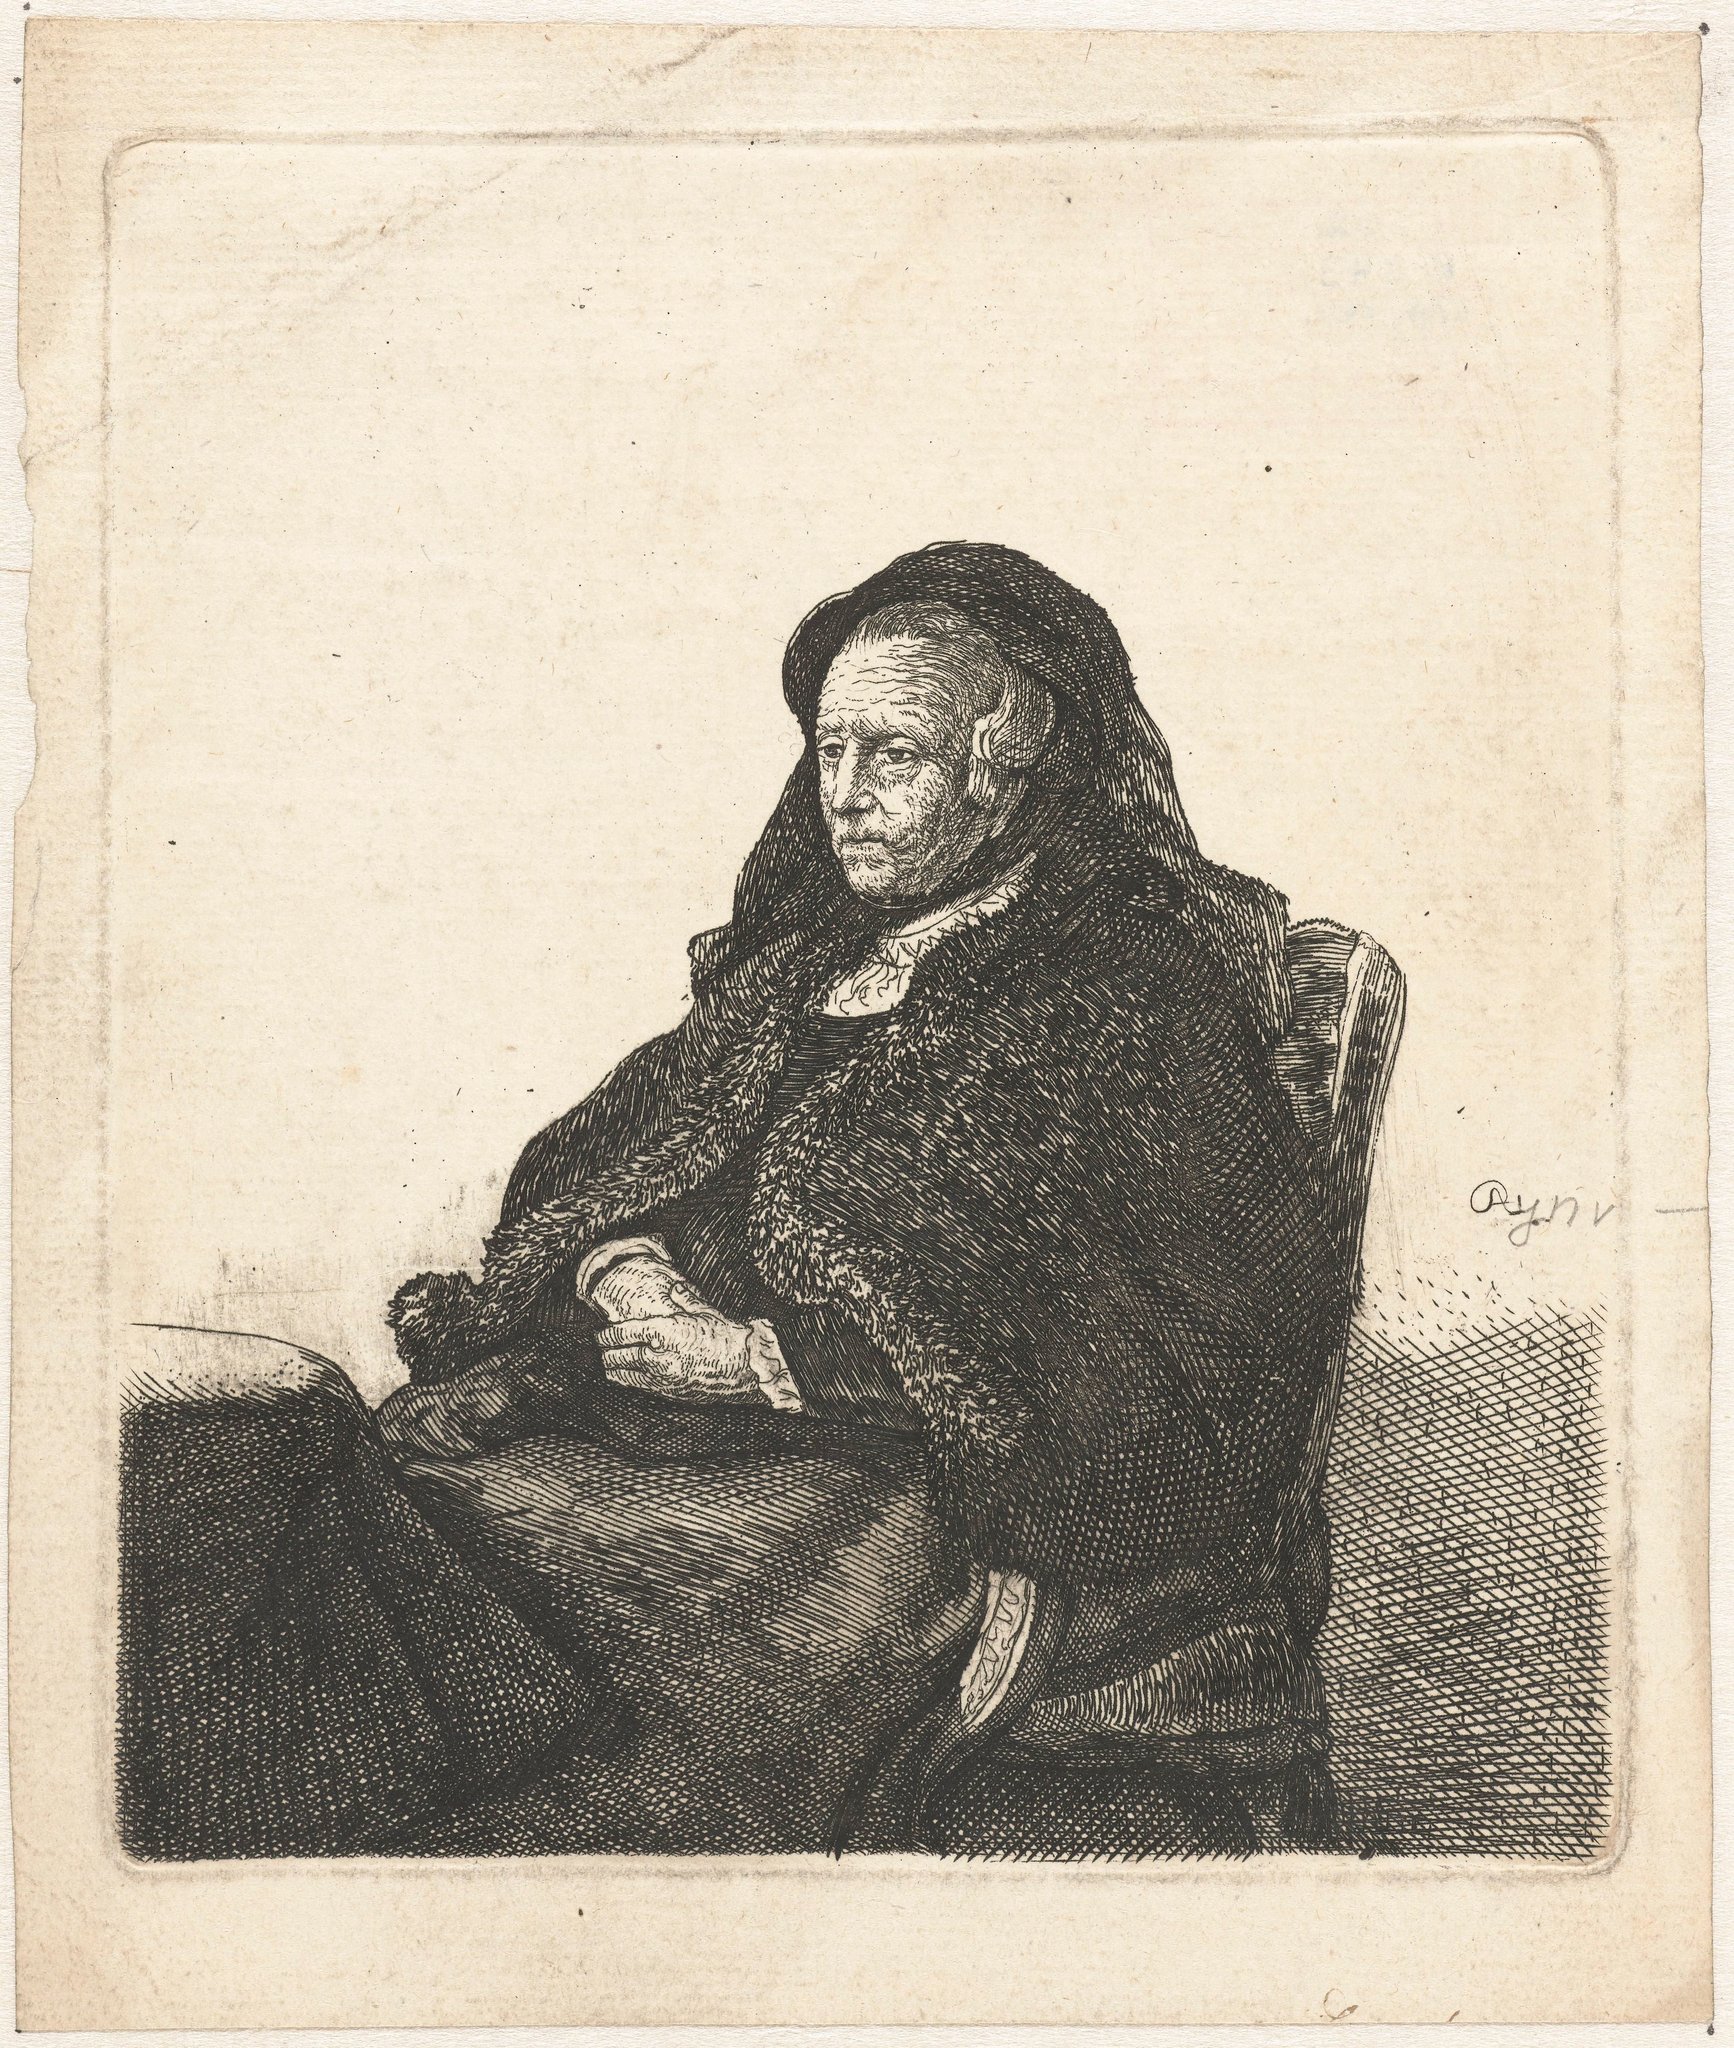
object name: print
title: The artist's mother seated at a table, looking right: three quarter length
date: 1631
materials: paper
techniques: etching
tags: historical persons - bb - woman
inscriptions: signature: ‘ijn v’, collector's mark: Lugt 2228, collector's mark: Lugt 2760, stamp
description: Spiegelbeeldige kopie naar de gelijknamige prent van Rembrandt.